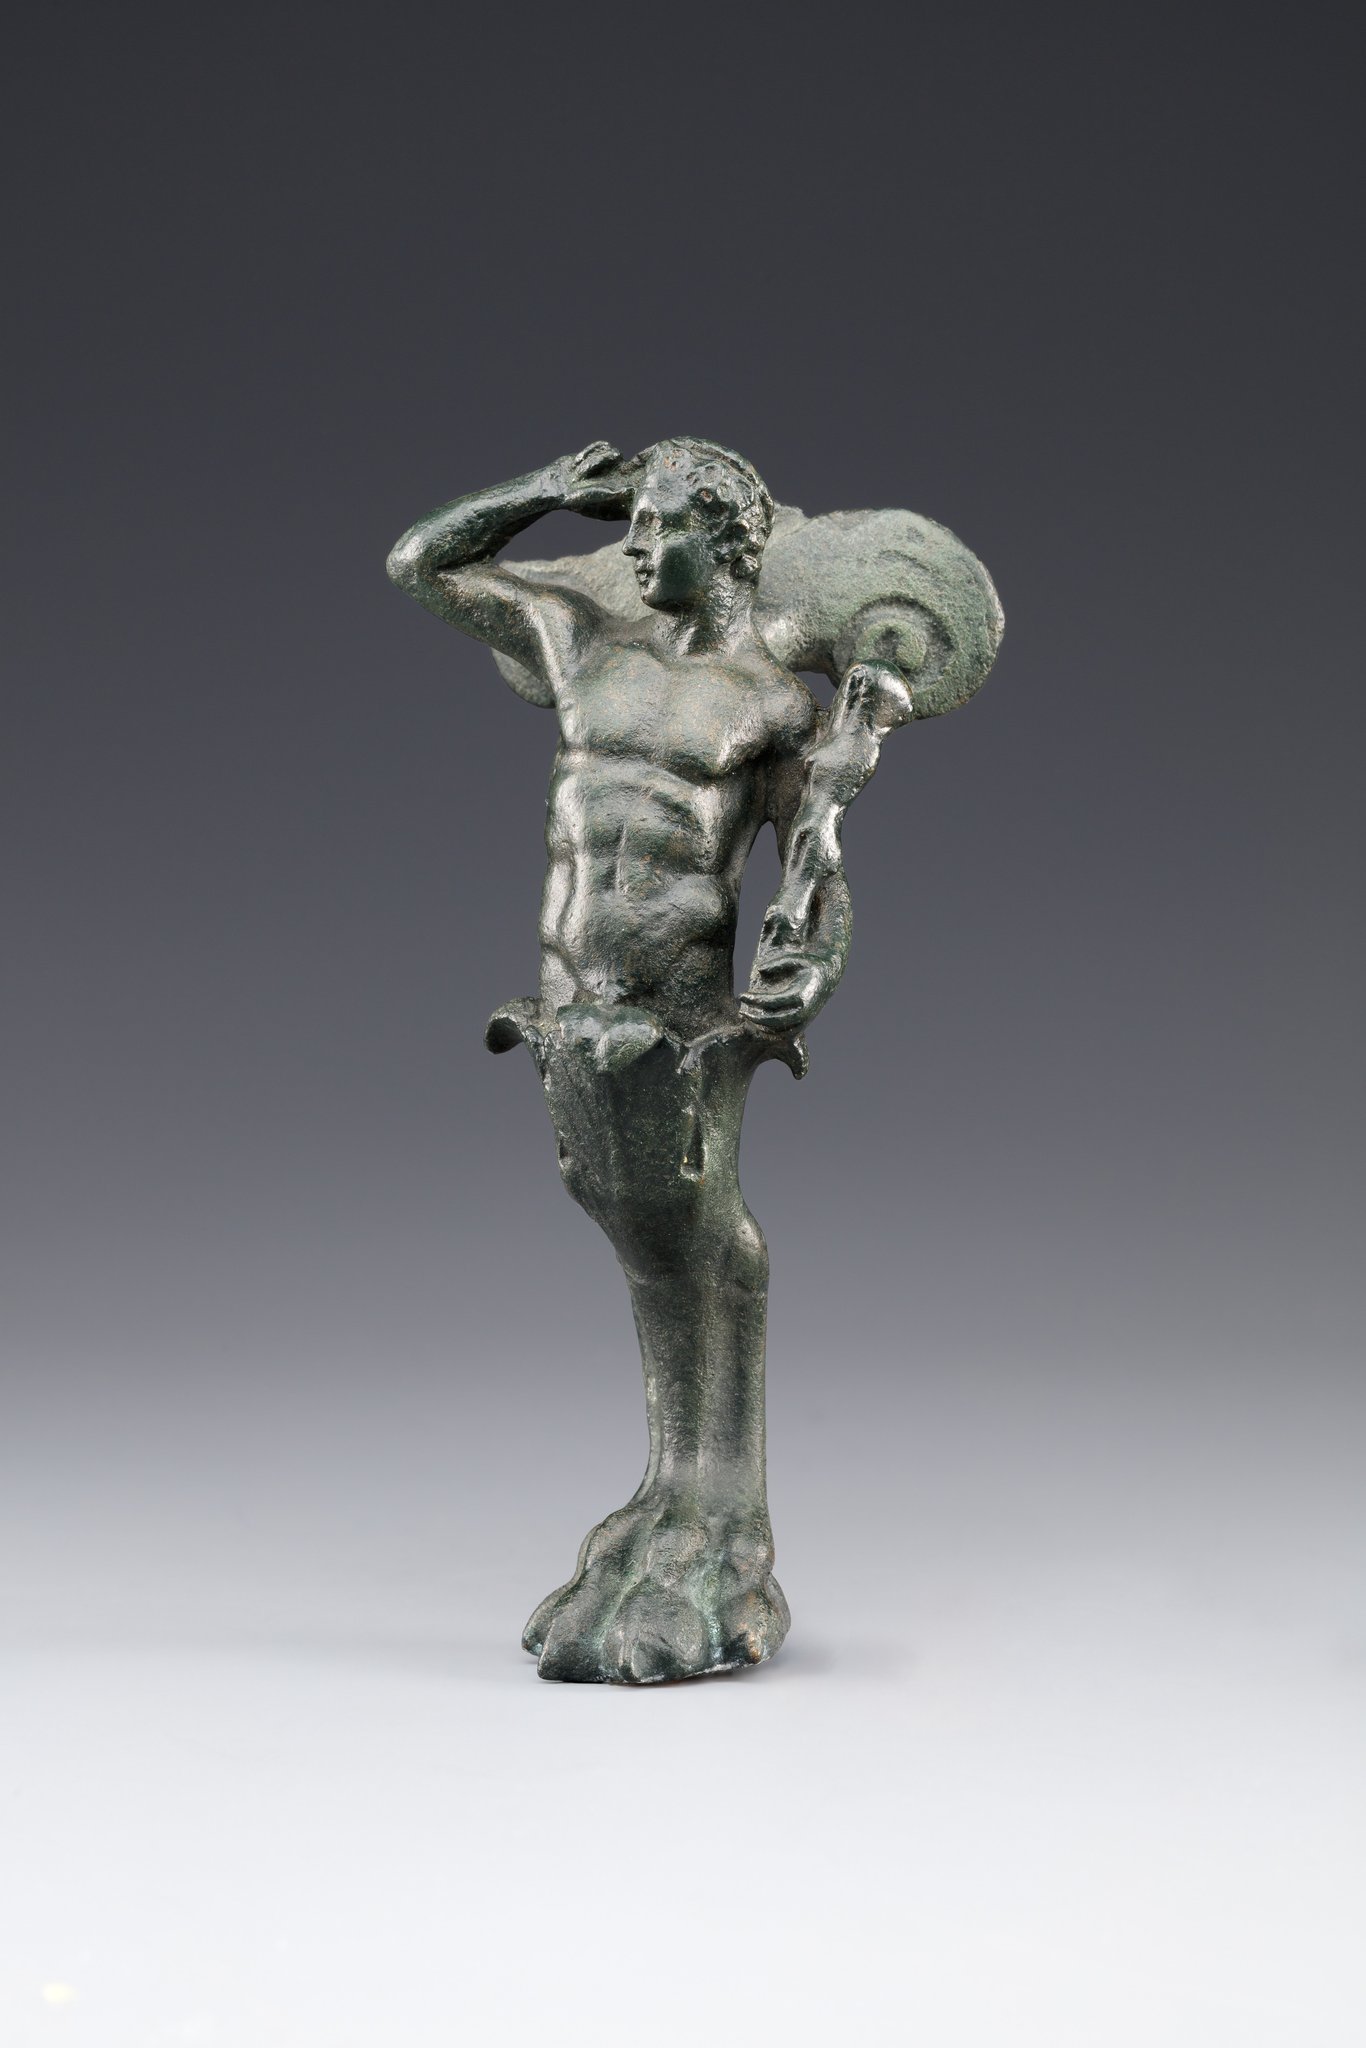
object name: vessel handle support, herakles, lion's foot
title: Vessel support combining the upper body of Herakles and a lion's foot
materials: bronze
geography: egypt